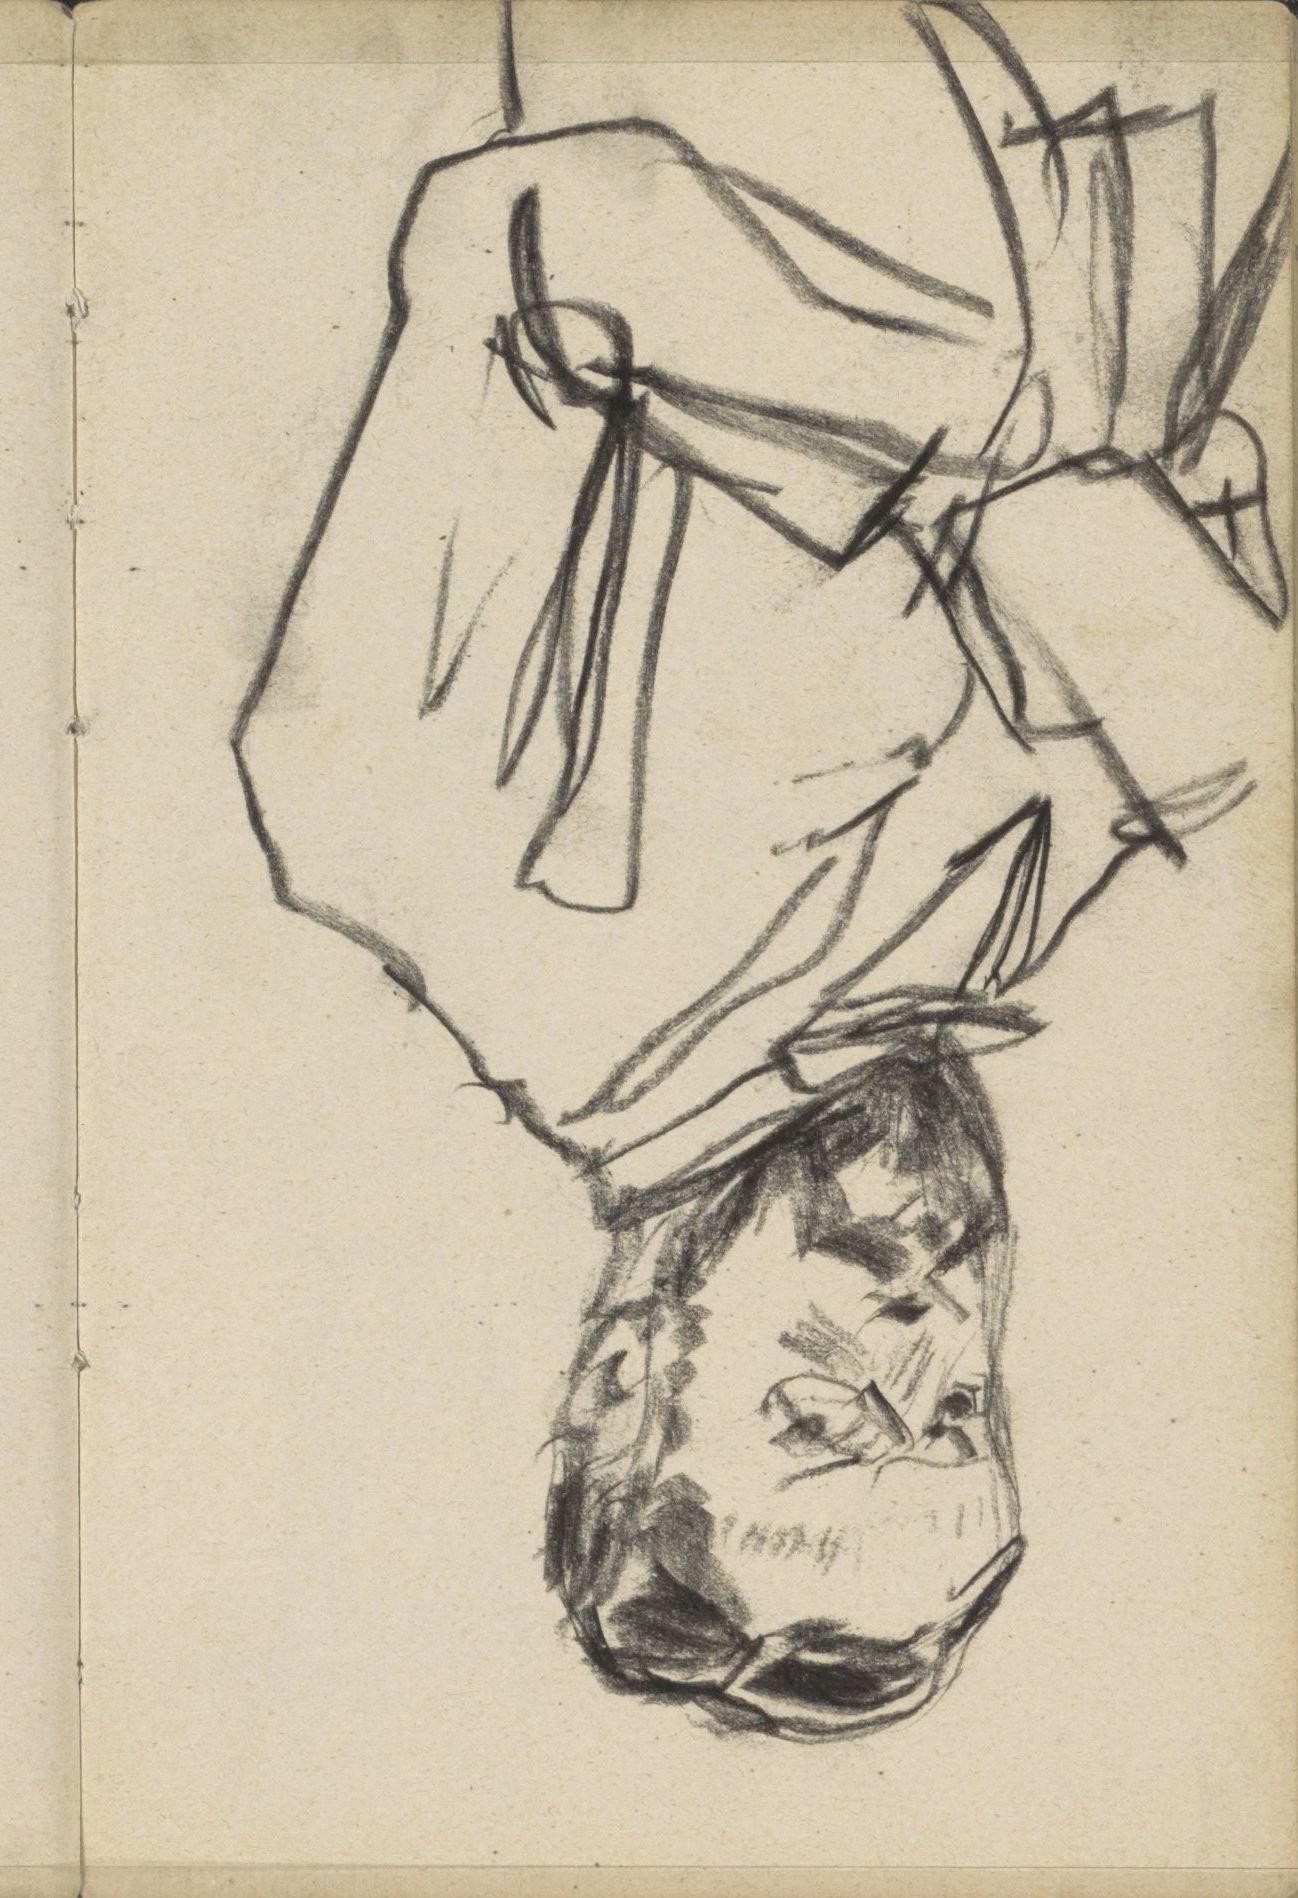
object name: sketchbook leaf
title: Zelfportret van George Hendrik Breitner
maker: george hendrik breitner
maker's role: draughtsman, painter, print maker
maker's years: 1857-1923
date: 1903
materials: chalk, paper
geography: amsterdam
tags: rotterdam, amsterdam, painter, draughtsman, george hendrik breitner, portrait, self-portrait of artist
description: Zelfportret van George Hendrik Breitner. Pagina 54 uit een schetsboek met 46 bladen.